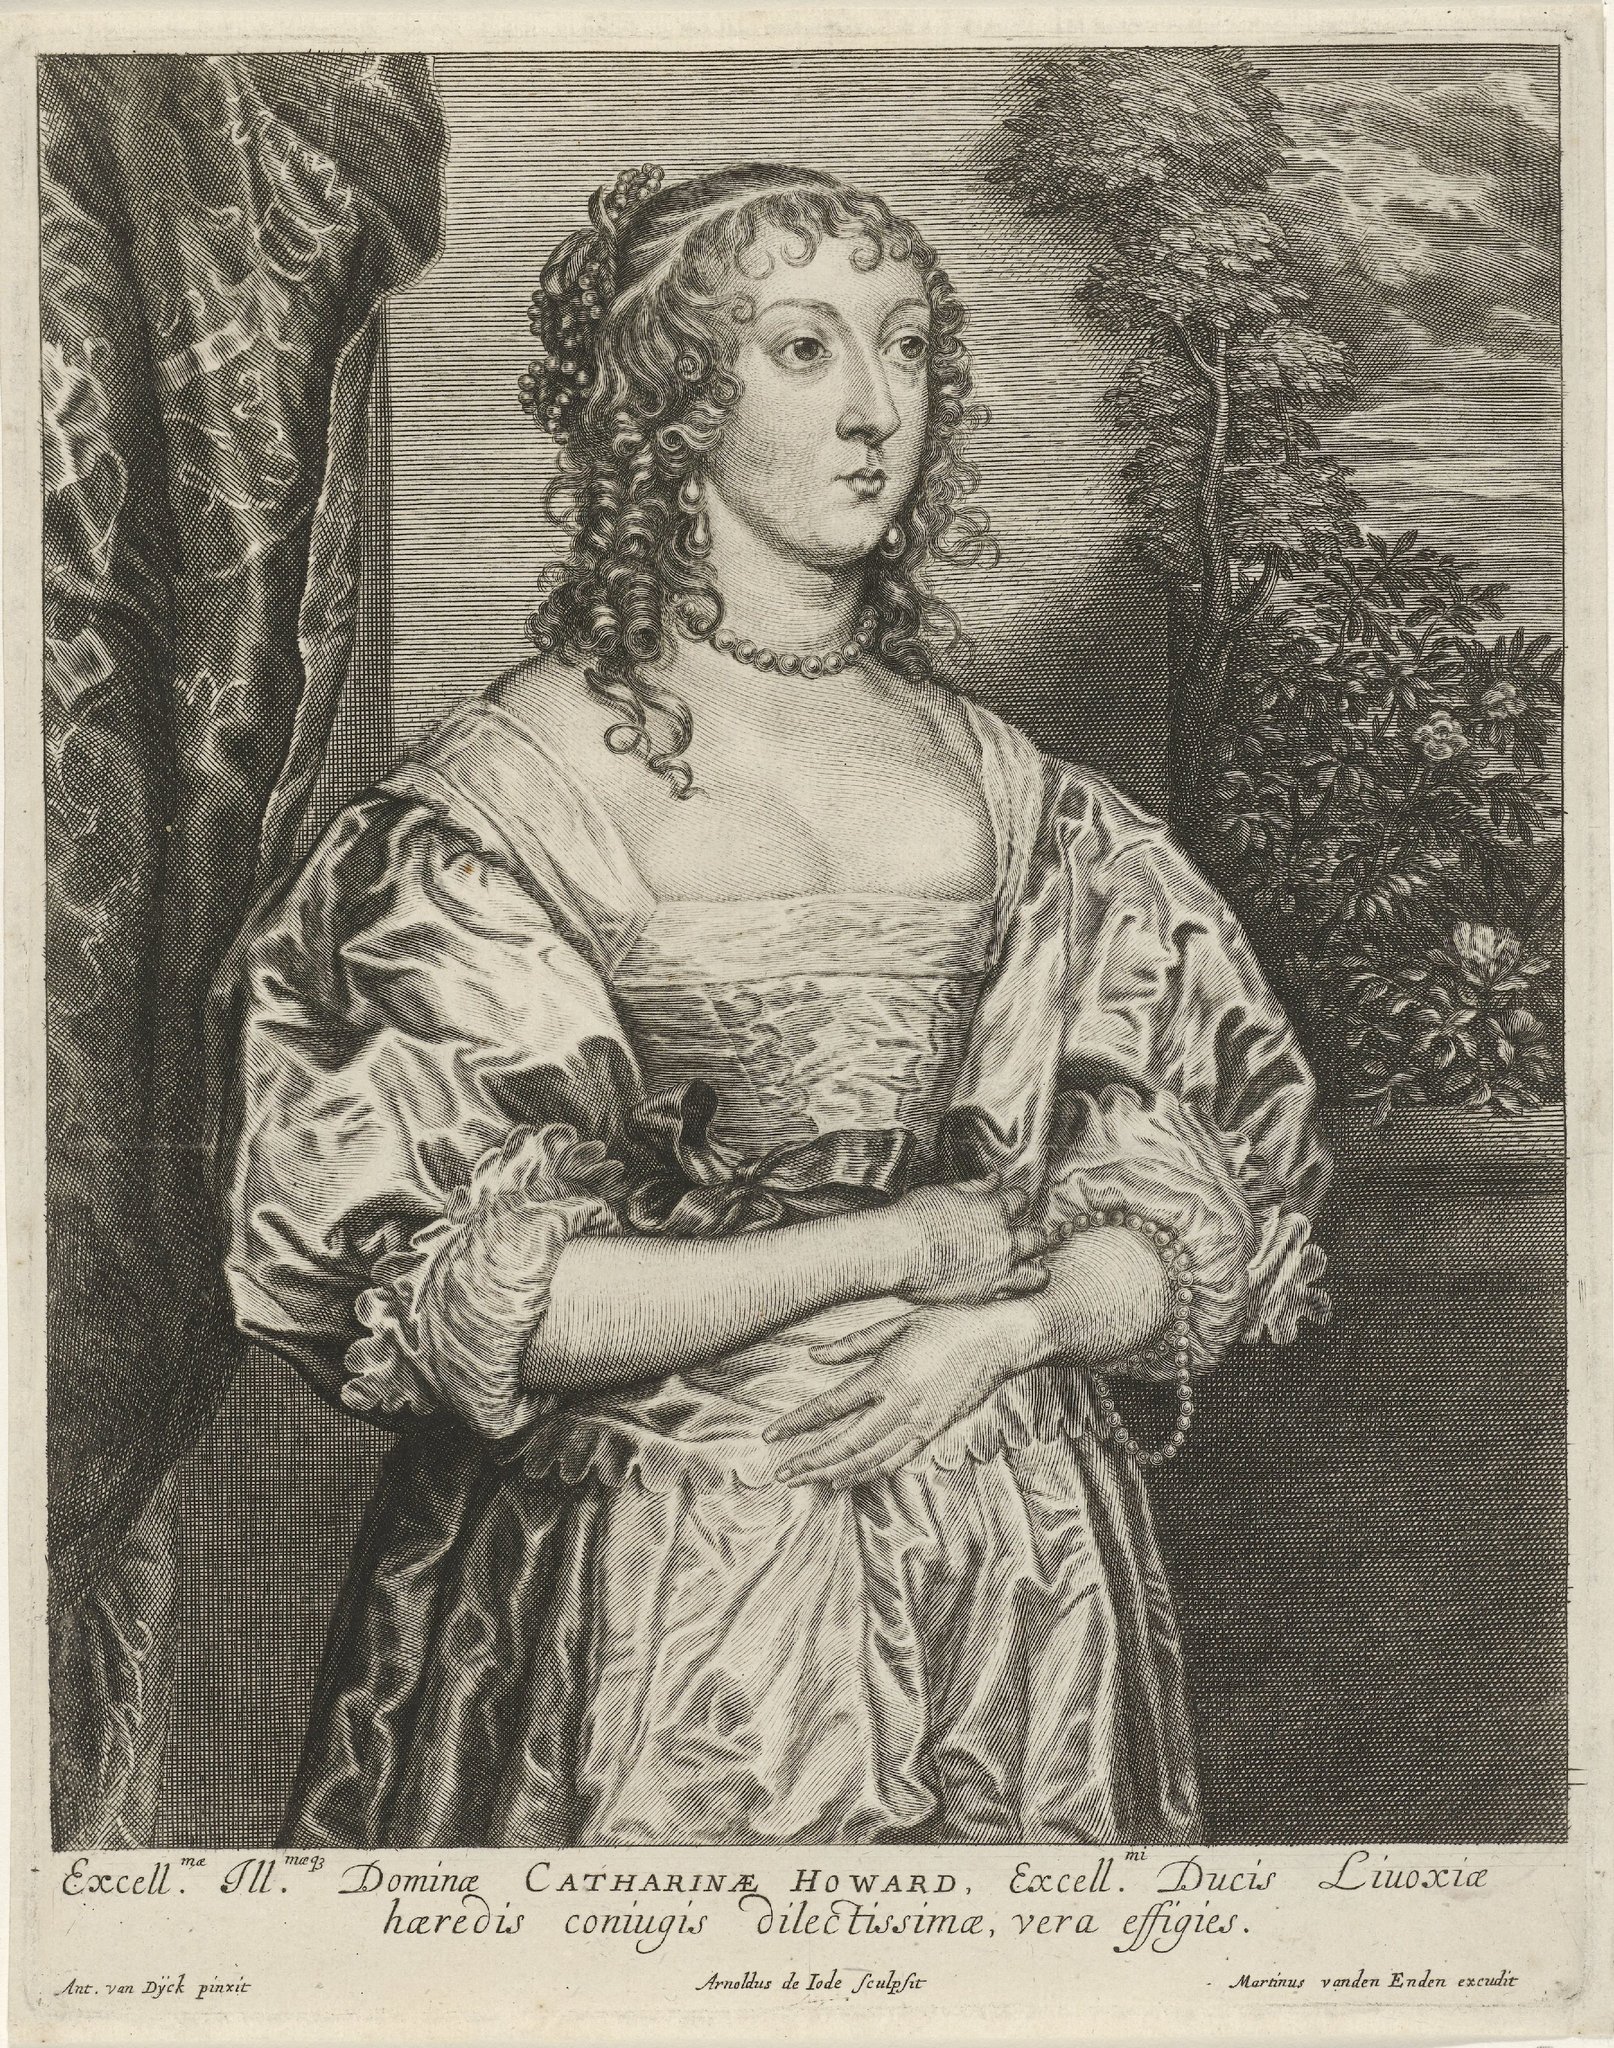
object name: print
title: Portret van Katherine Howard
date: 1658-1666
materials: paper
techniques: engraving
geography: antwerp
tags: historical persons - bb - woman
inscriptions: collector's mark: Lugt 240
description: Portret van hertogin Katherine Howard. Ze draagt een japon van satijn. In de marge de naam en functie van de geportretteerde in het Latijn.